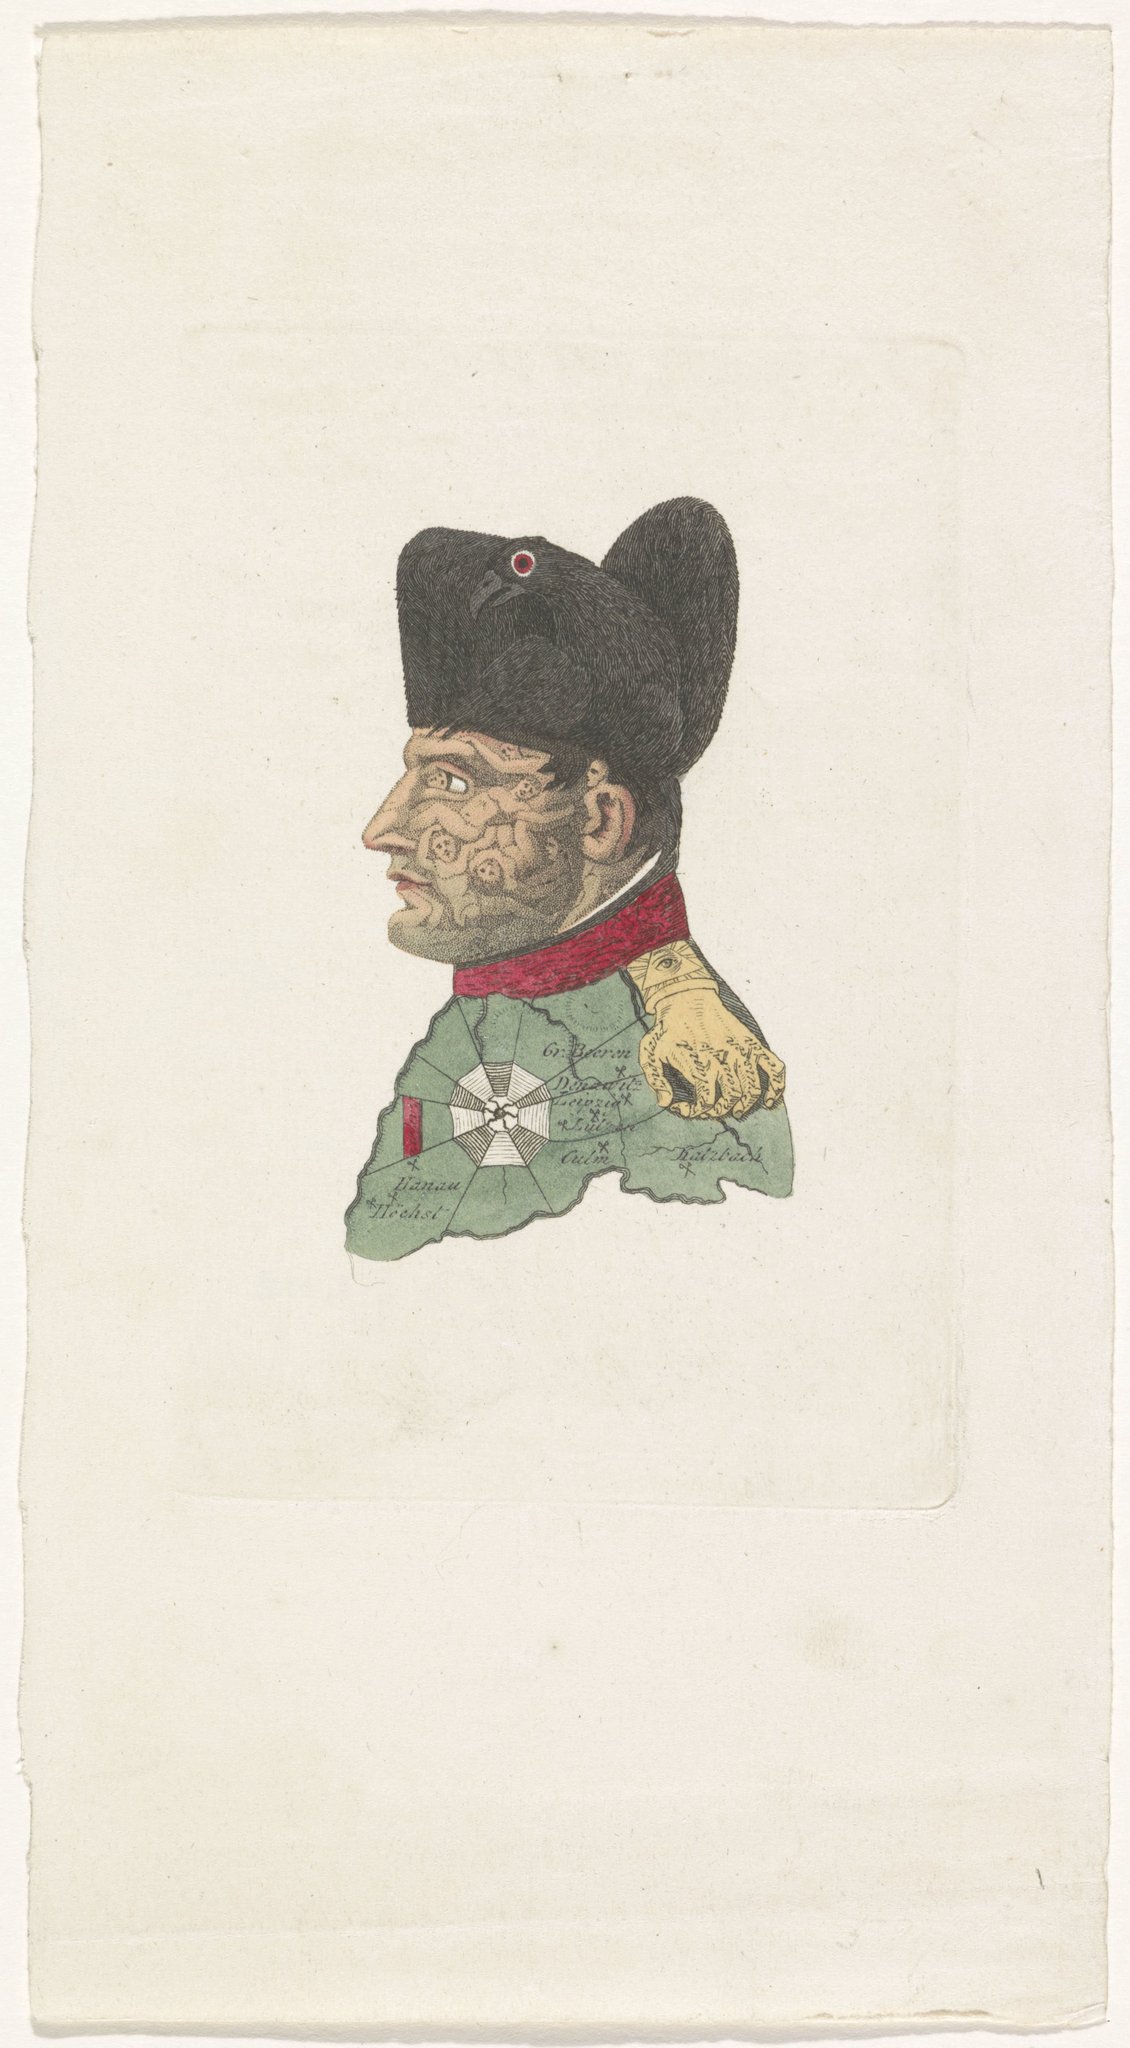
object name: print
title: Spotprent op Napoleon, 1813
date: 1813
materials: paper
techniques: etching, hand coloring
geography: netherlands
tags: napoleon i (emperor of the french), political caricatures and satires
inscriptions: collector's mark: Lugt 2228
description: Spotprent op Napoleon van 1813 waarbij zijn gezicht is opgebouwd uit de lijken van zijn slachtoffers, zijn hoed is de Pruisische adelaar, zijn epaulet is een grijpende hand waarvan de vingers zijn vijanden zijn en de pols het Alziende Oog. De kraag is een rivier van bloed, zijn jas het slagveld van Europa en het ordeteken van het Legioen van Eer op zijn borst is een spinnenweb. Bij de prent behoort een afzonderlijke verklaring.